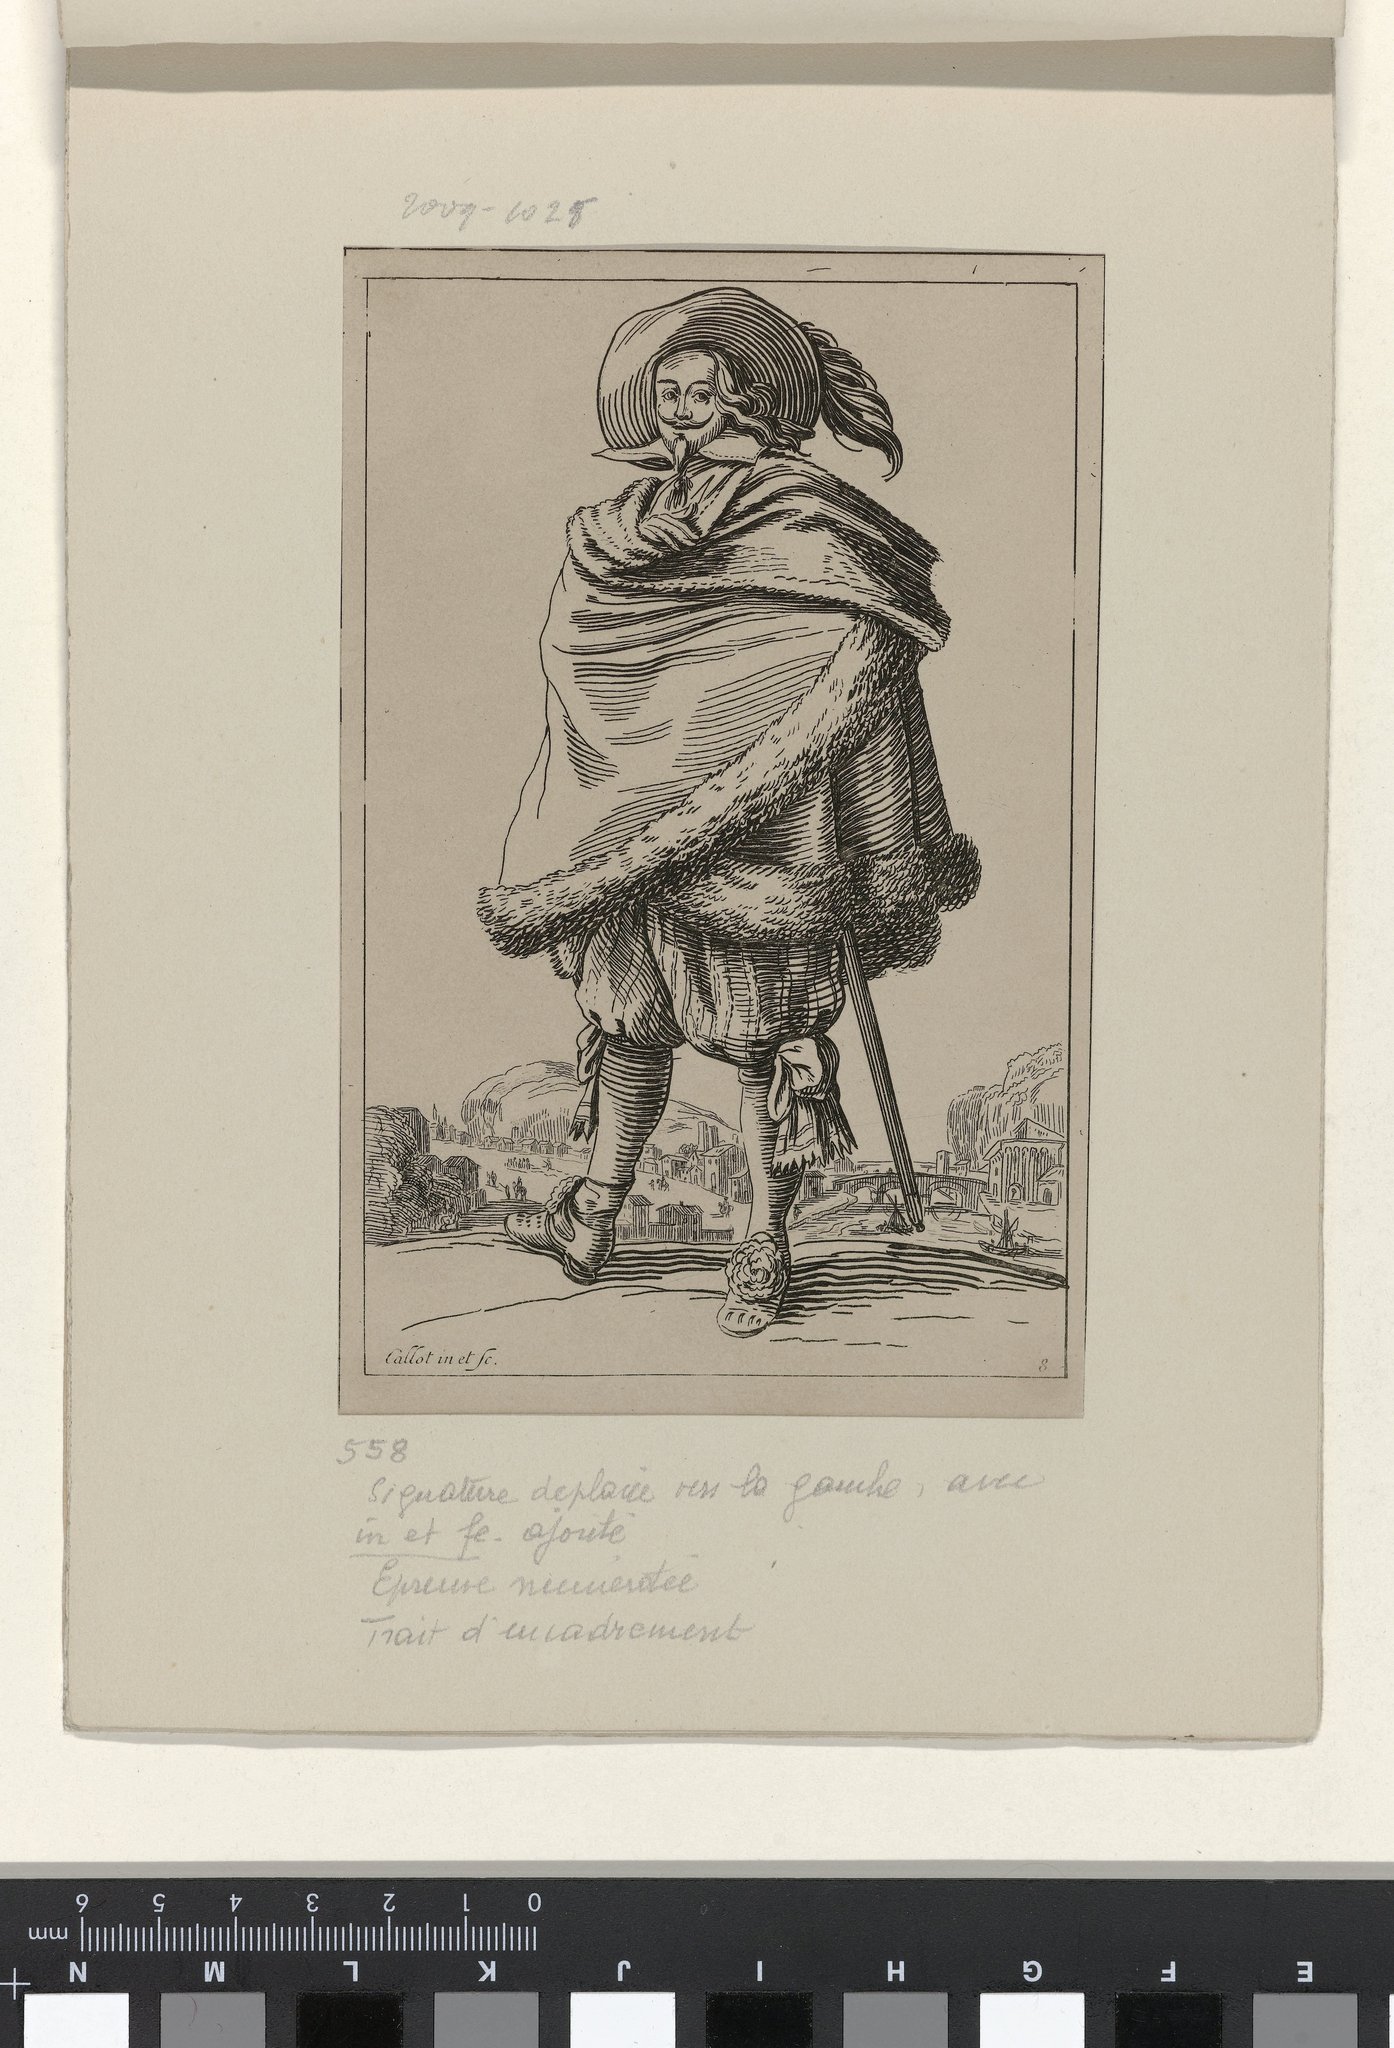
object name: print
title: Edelman met gepluimde hoed en bontcape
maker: Anonymous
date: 1700-1799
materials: paper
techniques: etching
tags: head-gear: hat (+ fur used for clothes), cape (+ men's clothes), cape (+ fur used for clothes), hacking and thrusting weapons: dagger, head-gear: hat (+ men's clothes), shoes, sandals (+ men's clothes), clothes, costume (+ men's clothes), trousers, breeches, etc. (breeches) (+ men's clothes), clothing for the upper part of the body (doublet) (+ men's clothes)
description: Staande heer, gekleed in een cape afgezet met bont, schoenen met rozetten aan de voeten, een hoed met brede rand en veer op het hoofd. Op de achtergrond een rivierlandschap met een stadje en een brug. Late kopie van no. 8 uit La Noblesse de Lorraine: serie van 12 prenten met edellieden in kostuums die gedragen werden in Lotharingen in het eerste kwart van de 17e eeuw.